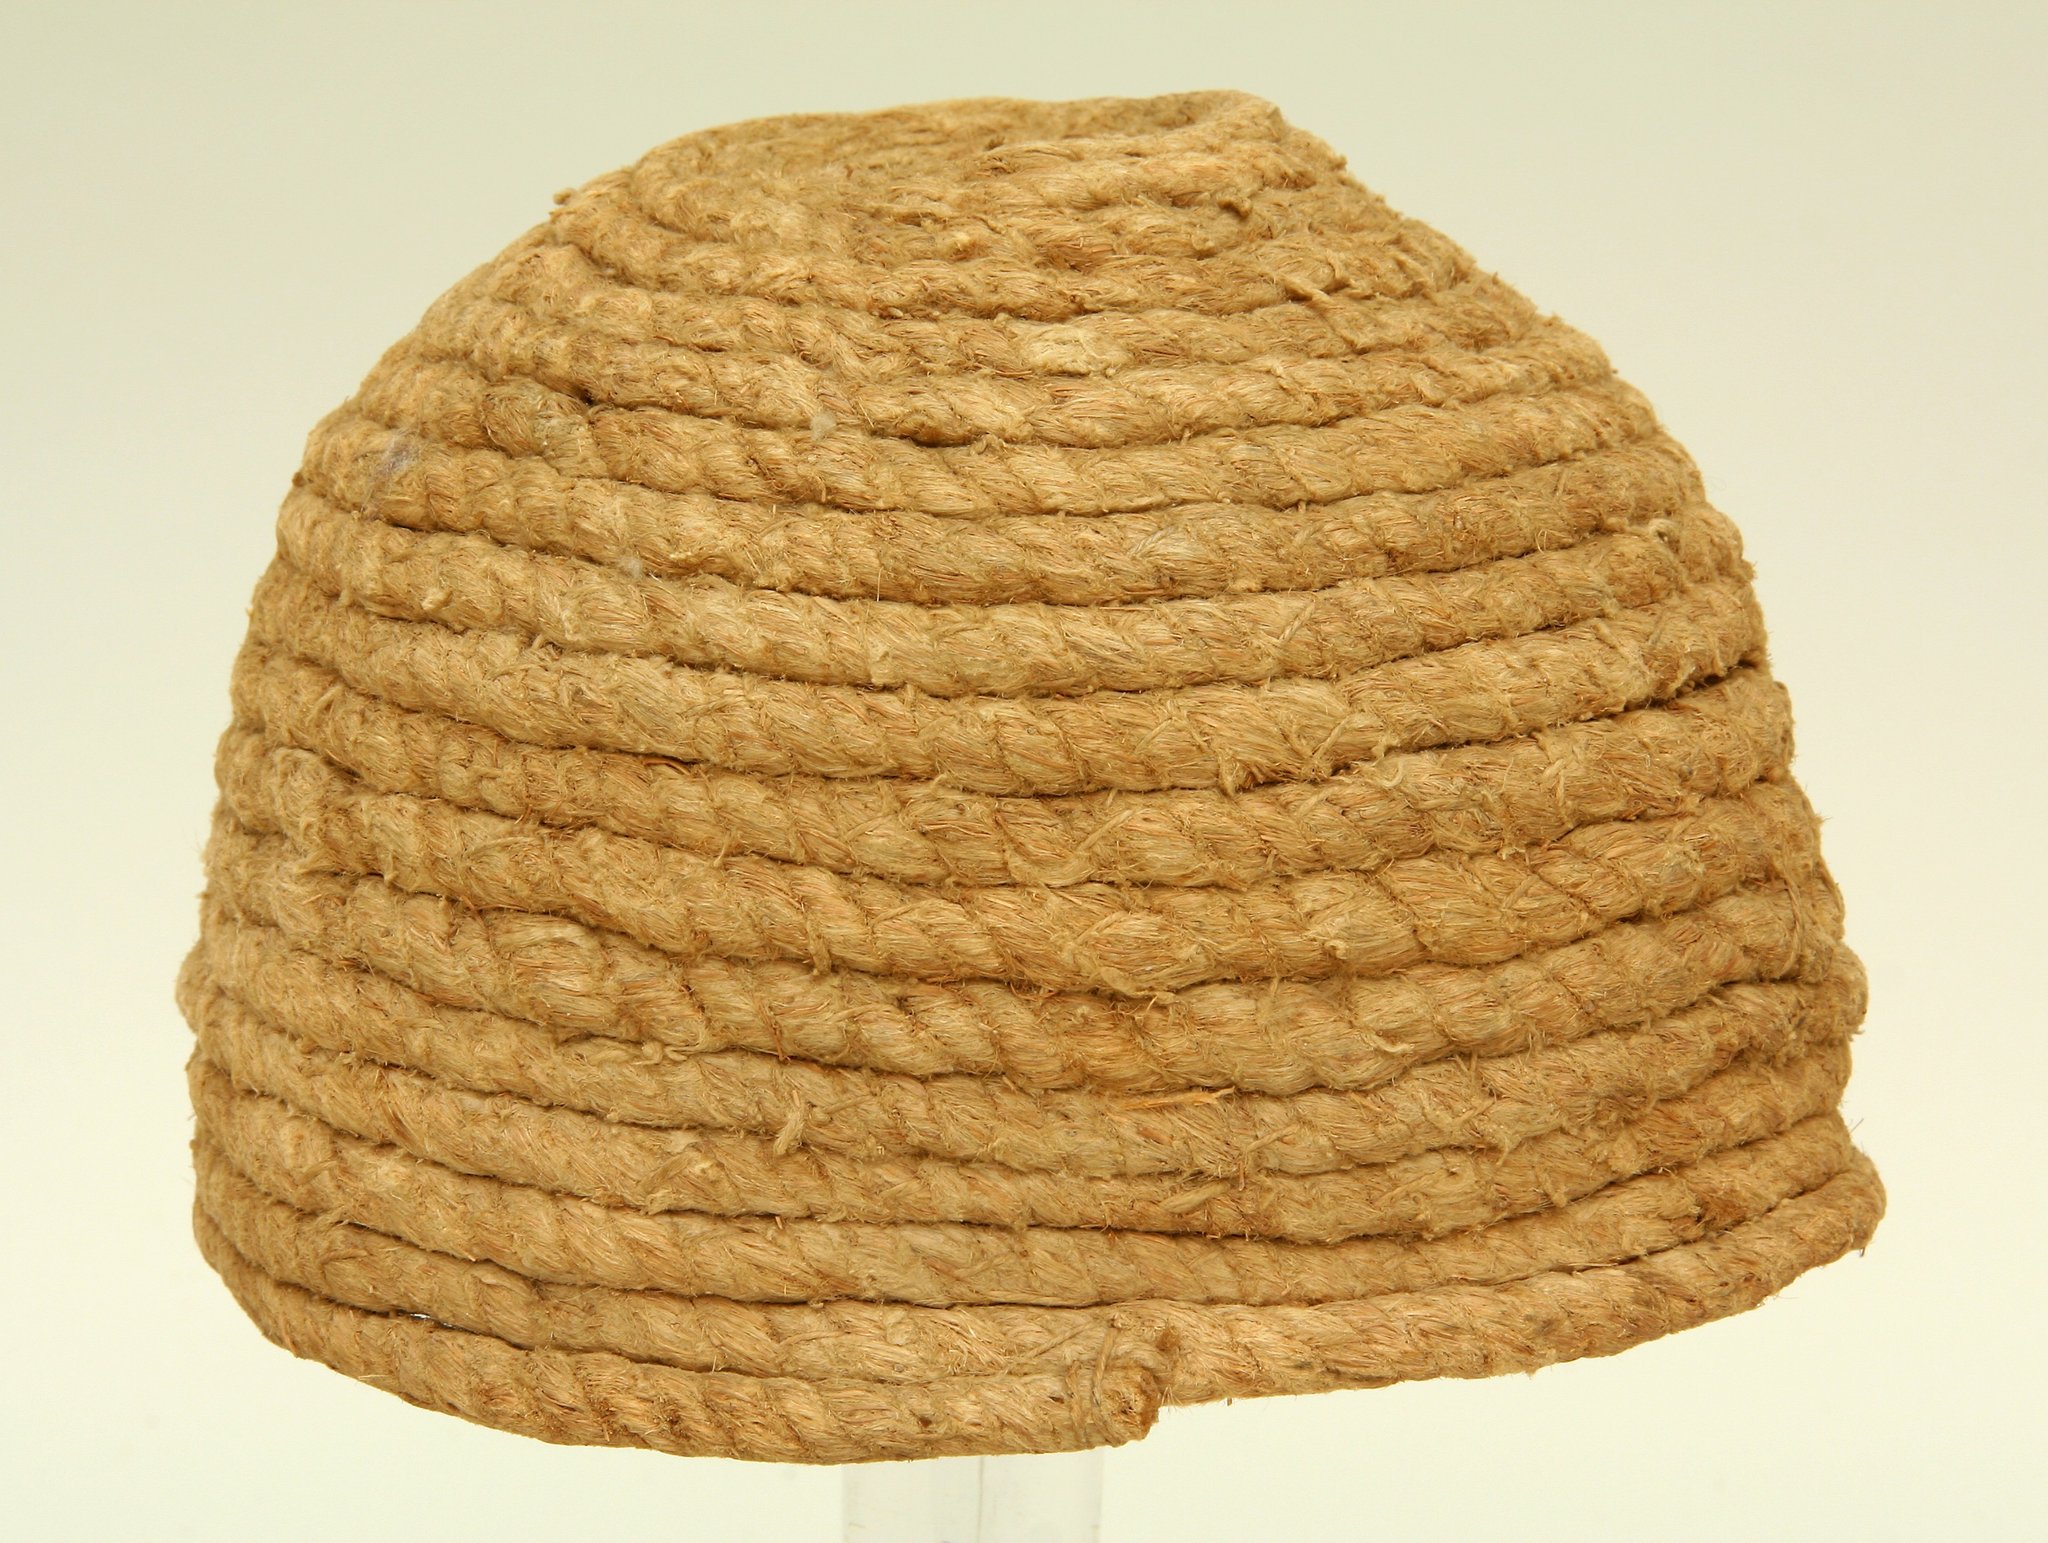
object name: cerveliere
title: Cerveliere (Cap Worn Under Mail)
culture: german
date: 1401-1500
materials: fiber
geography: germany